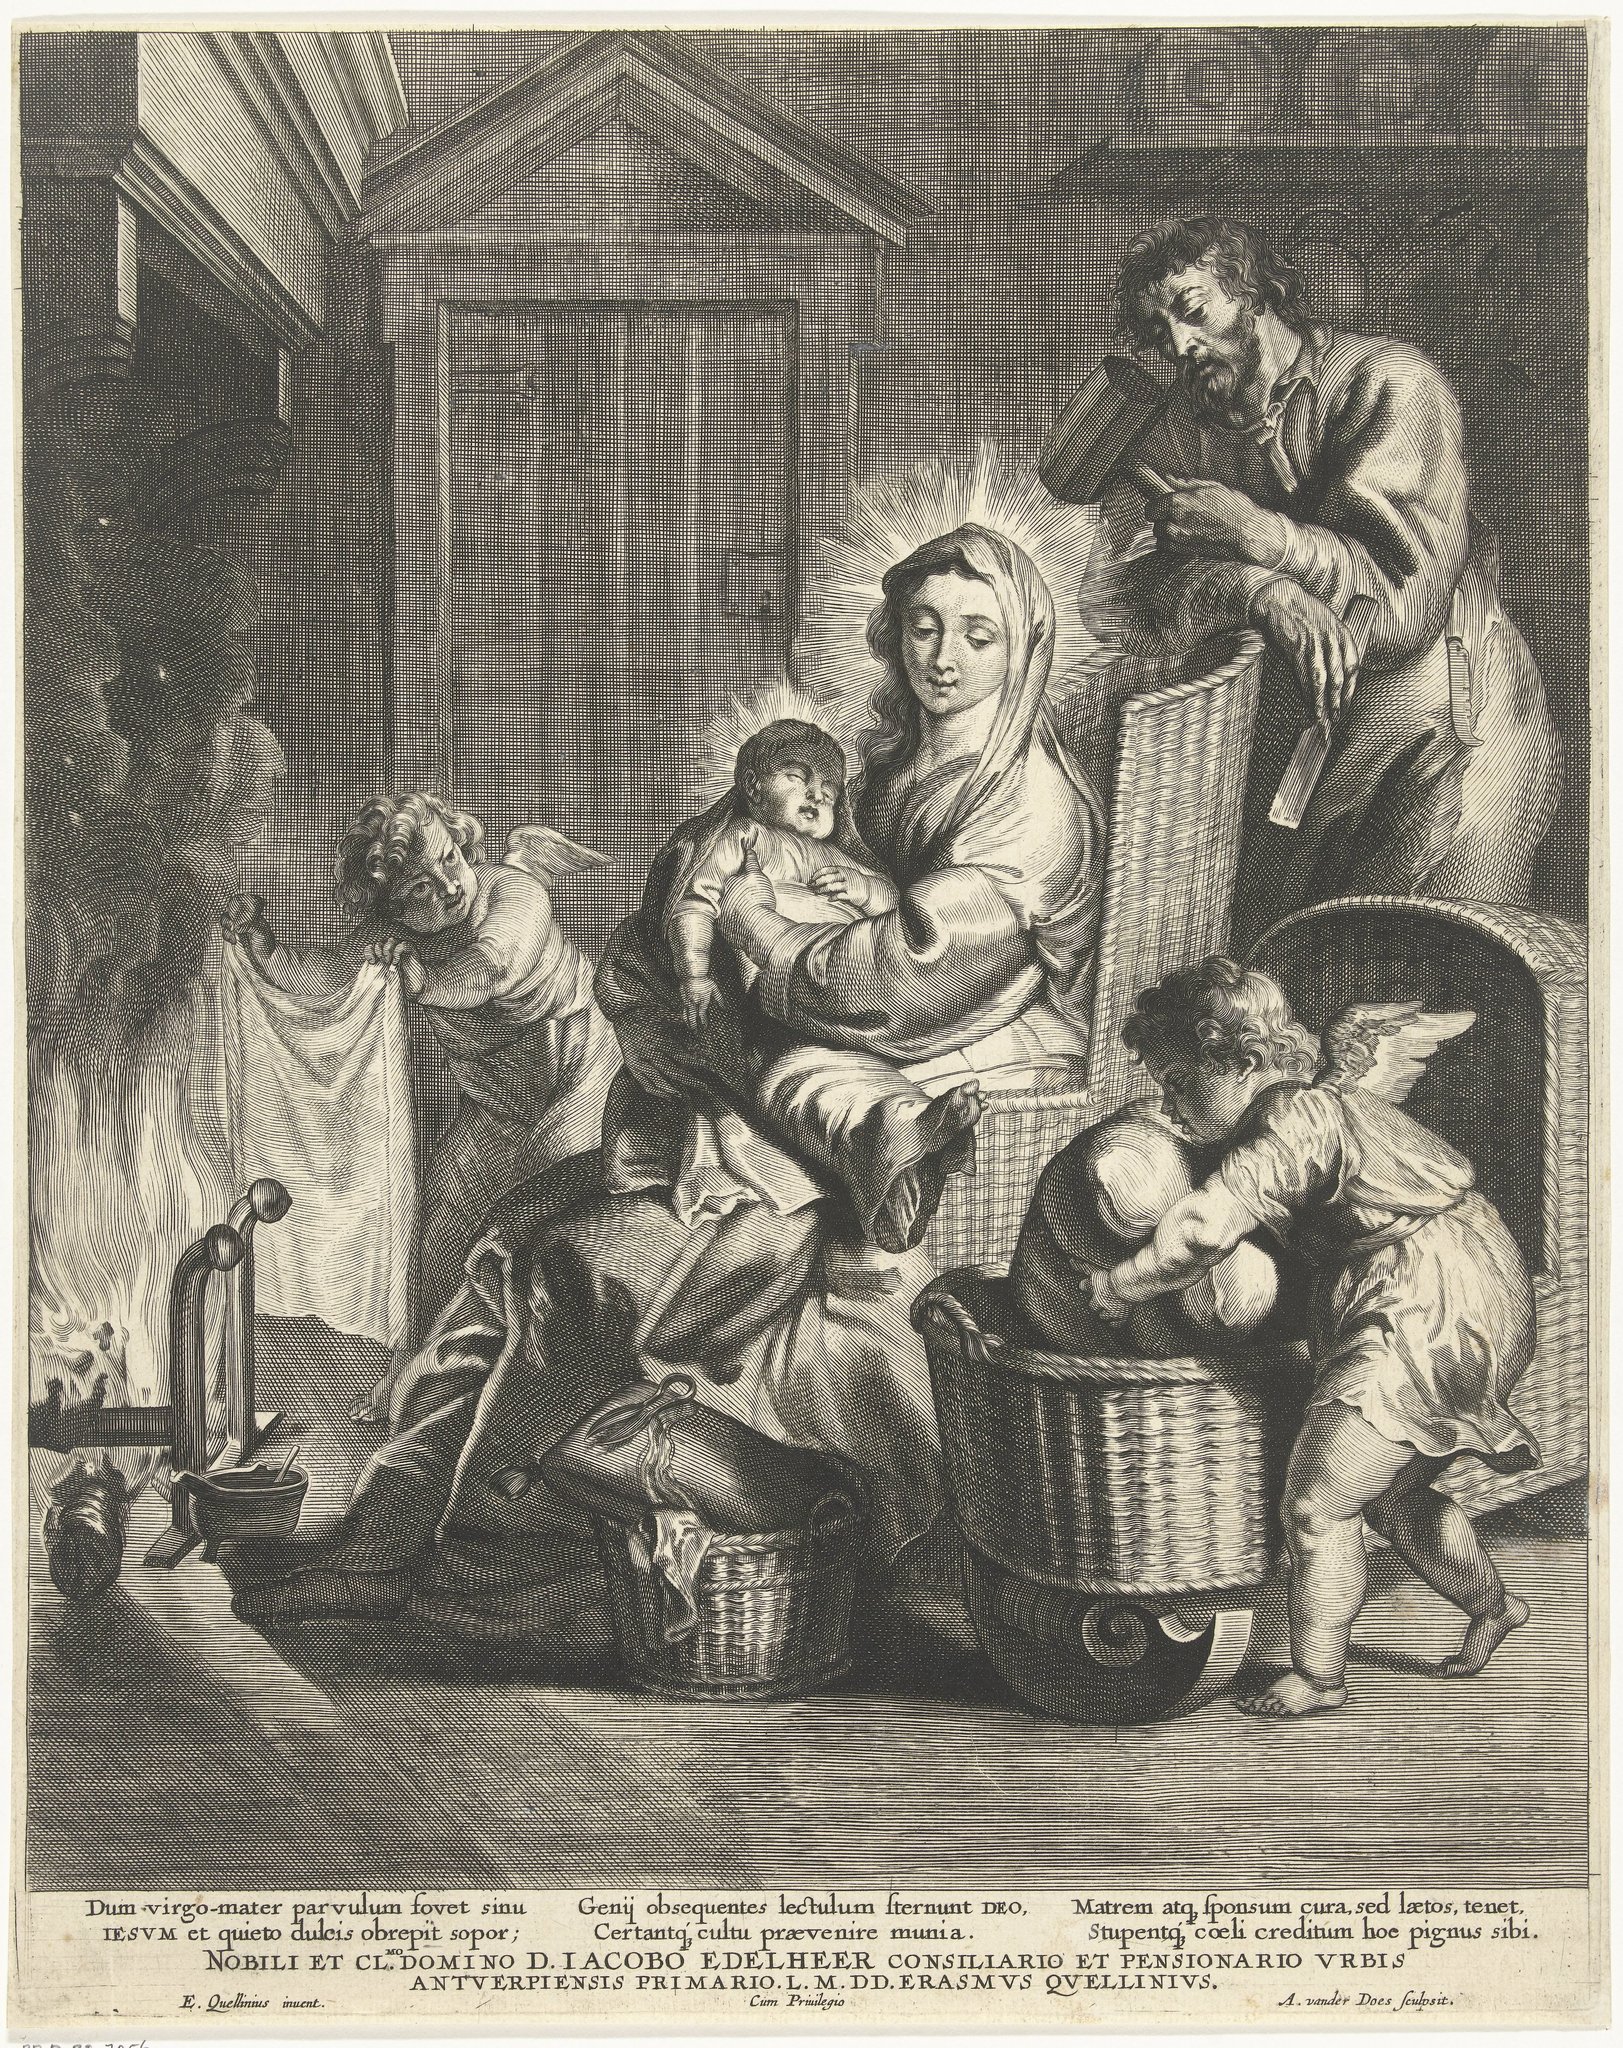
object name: print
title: Heilige familie in interieur met twee engelen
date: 1632-1657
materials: paper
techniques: engraving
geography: southern netherlands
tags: holy family, and derived representations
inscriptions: collector's mark: Lugt 240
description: Heilige familie in interieur met twee engelen. Maria met kind zittend bij haard, Jozef staand met gereedschappen in zijn handen. Engel maakt de wieg gereed voor het slapende kind. In ondermarge Latijnse tekst in vier regels